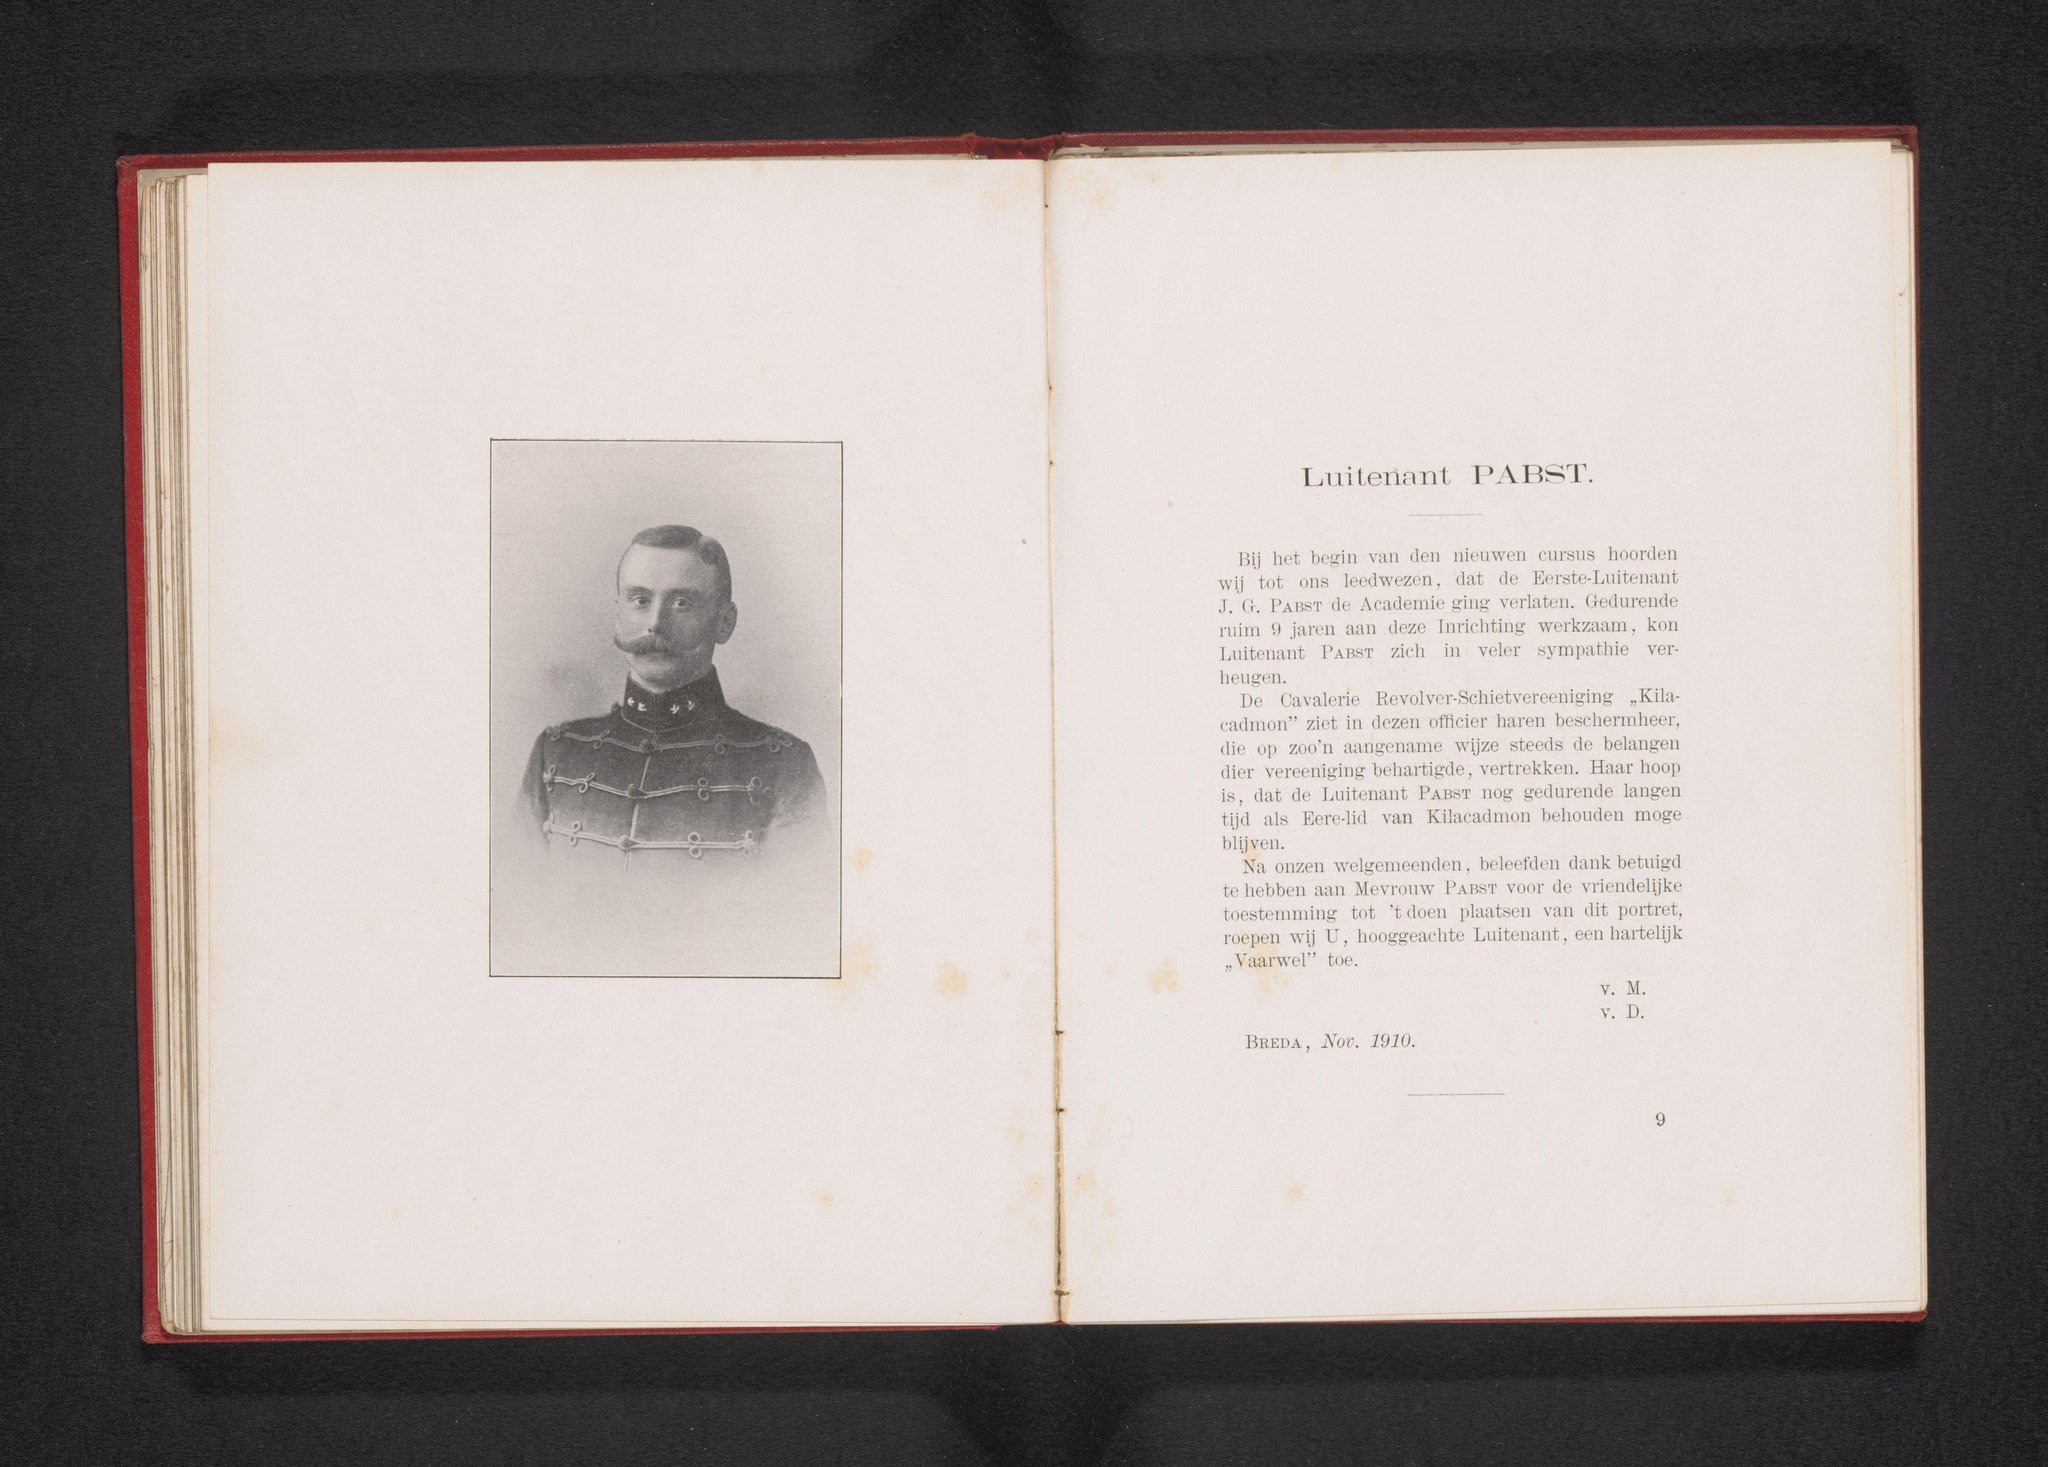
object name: photomechanical print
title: Portret van luitenant J.G. Pabst van de Koninklijke Militaire Academie in Breda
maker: Anonymous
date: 1905-1910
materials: paper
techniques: autotype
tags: historical persons